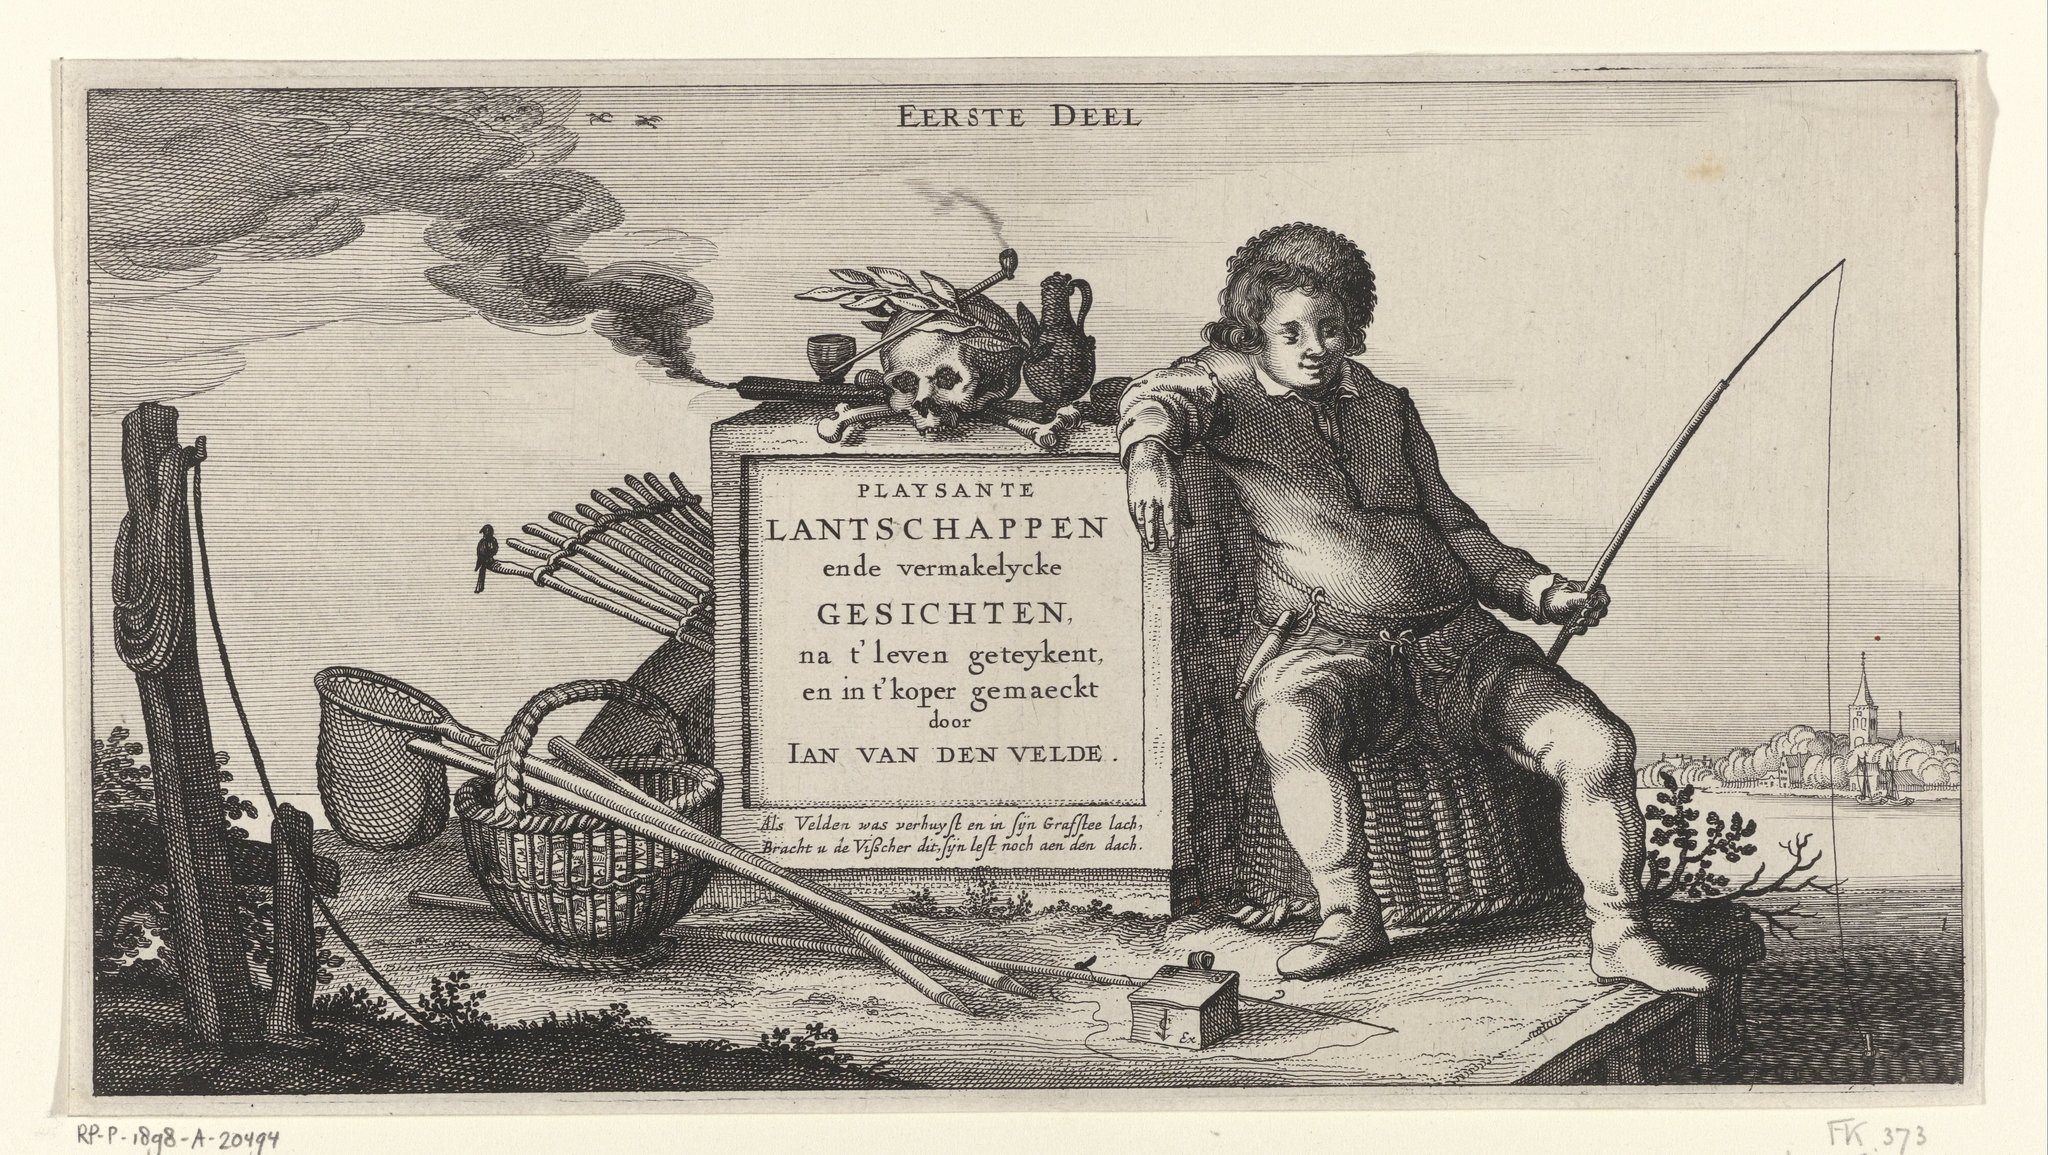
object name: print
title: Playsante lantschappen ende vermakelycke gesichten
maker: claes jansz. visscher (ii)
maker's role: draughtsman, print maker, publisher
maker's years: 1586-1652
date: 1641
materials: paper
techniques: engraving, etching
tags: container made of plant material other than wood: basket, skull as symbol of 'vanitas', crowning with laurel, fisherman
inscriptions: collector's mark: Lugt 964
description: Een hengelaar zit op een kade, leunend tegen een sokkel waarop verschillende vanitassymbolen: een gelauwerde schedel en een uitgedoofde pijp en kaars. Op de grond de attributen van het landleven zoals hark en vissersgerei. Op de sokkel is de titel van de prentserie vermeld. Onder de titel op de sokkel is te lezen dat Claes Jansz. Visscher de titelprent heeft vervaardigd na de dood van de graveur van de serie: Jan van de Velde (II). Titelprent van een serie met 36 prenten van landschappen, verdeeld over zes delen.